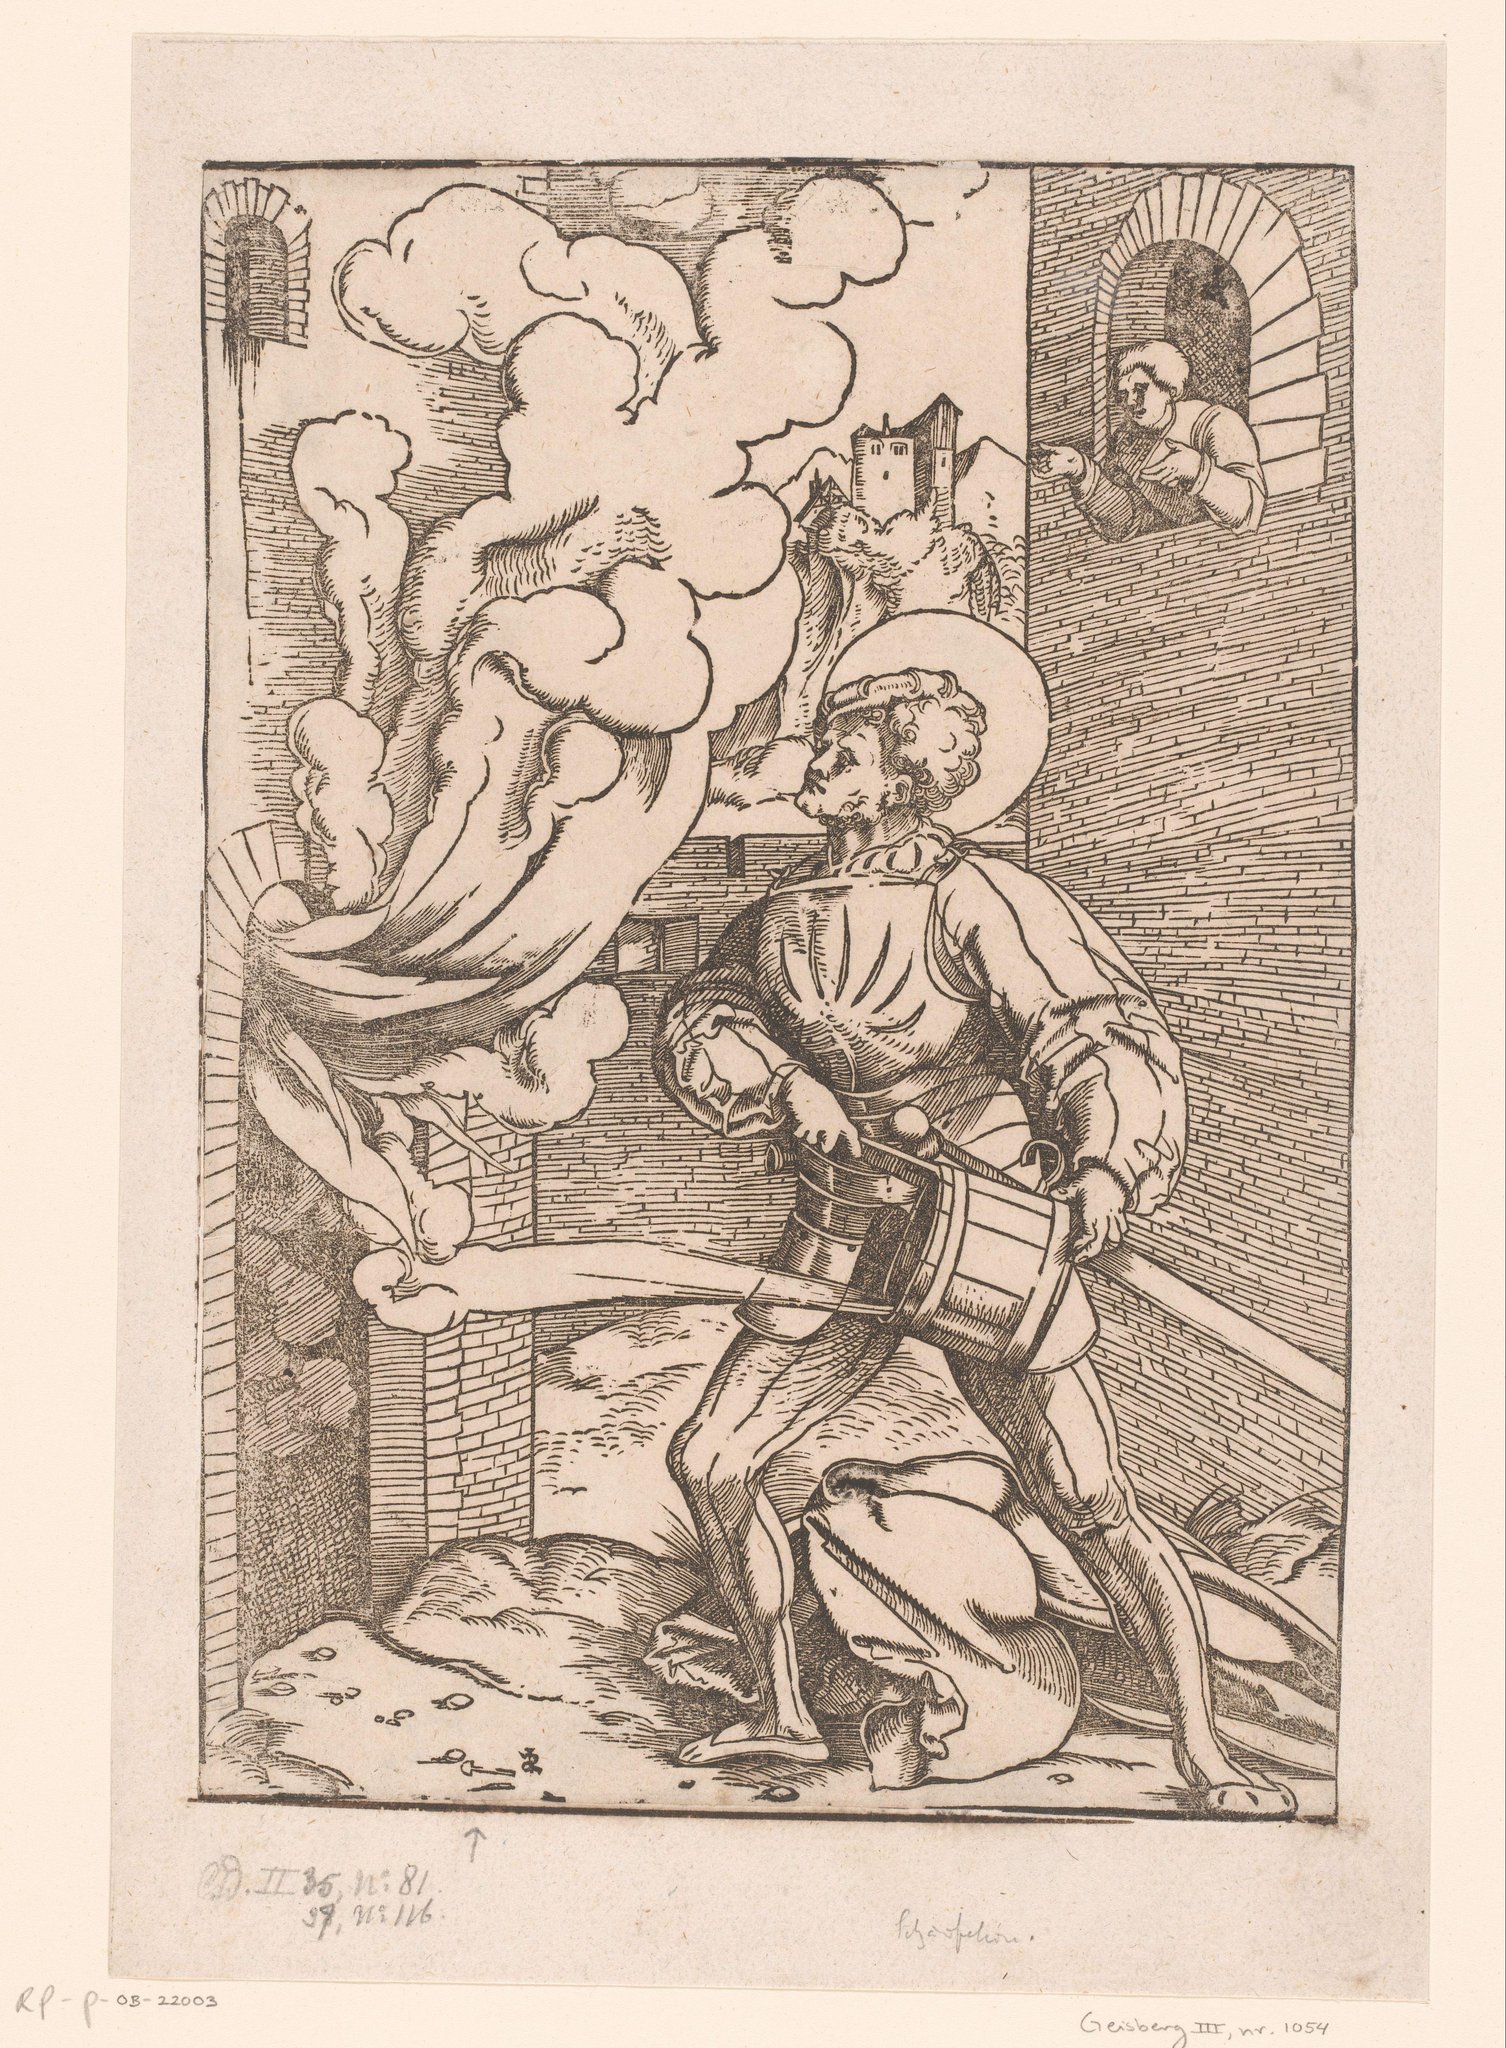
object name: print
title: Heilige Floriaan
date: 1500-1550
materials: paper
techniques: woodcut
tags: the soldier martyr florian of lorch; possible attributes: bucket (pitcher), lance with banner, millstone, palm-branch, shield (with cross), sword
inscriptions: collector's mark: Lugt 240